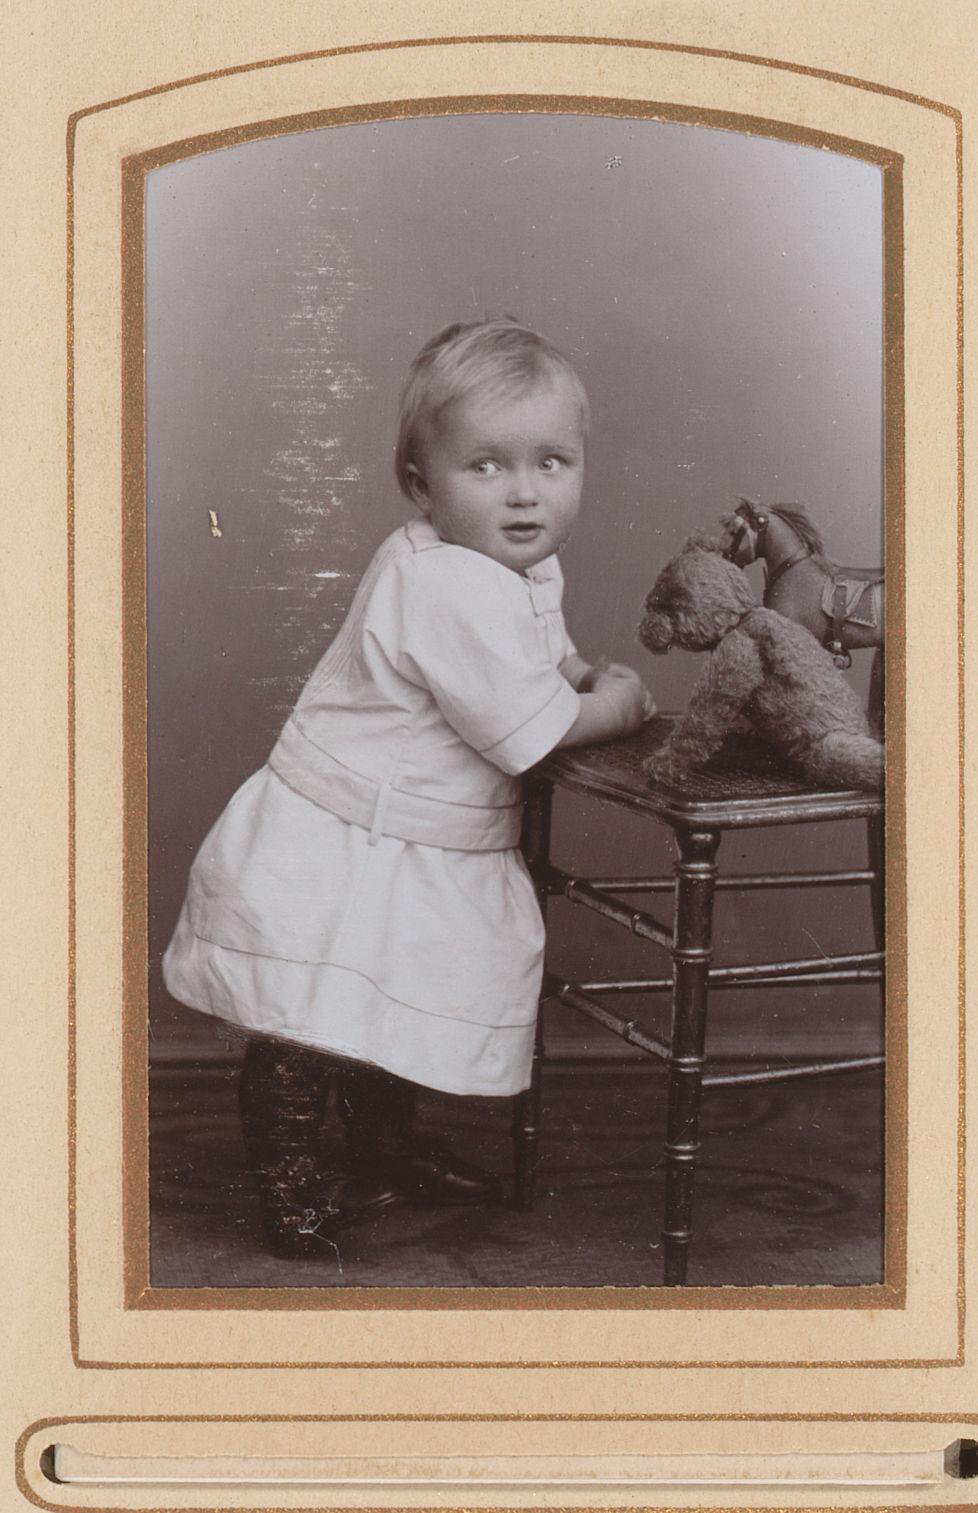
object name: album leaf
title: Portret van een kind, leunend op een stoel met speelgoed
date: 1880-1910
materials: cardboard, photographic support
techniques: collodion silver print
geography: germany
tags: leaning figure - aa - female human figure, child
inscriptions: inscription: ‘A. Wertheim/ Rosenthalerstr.’